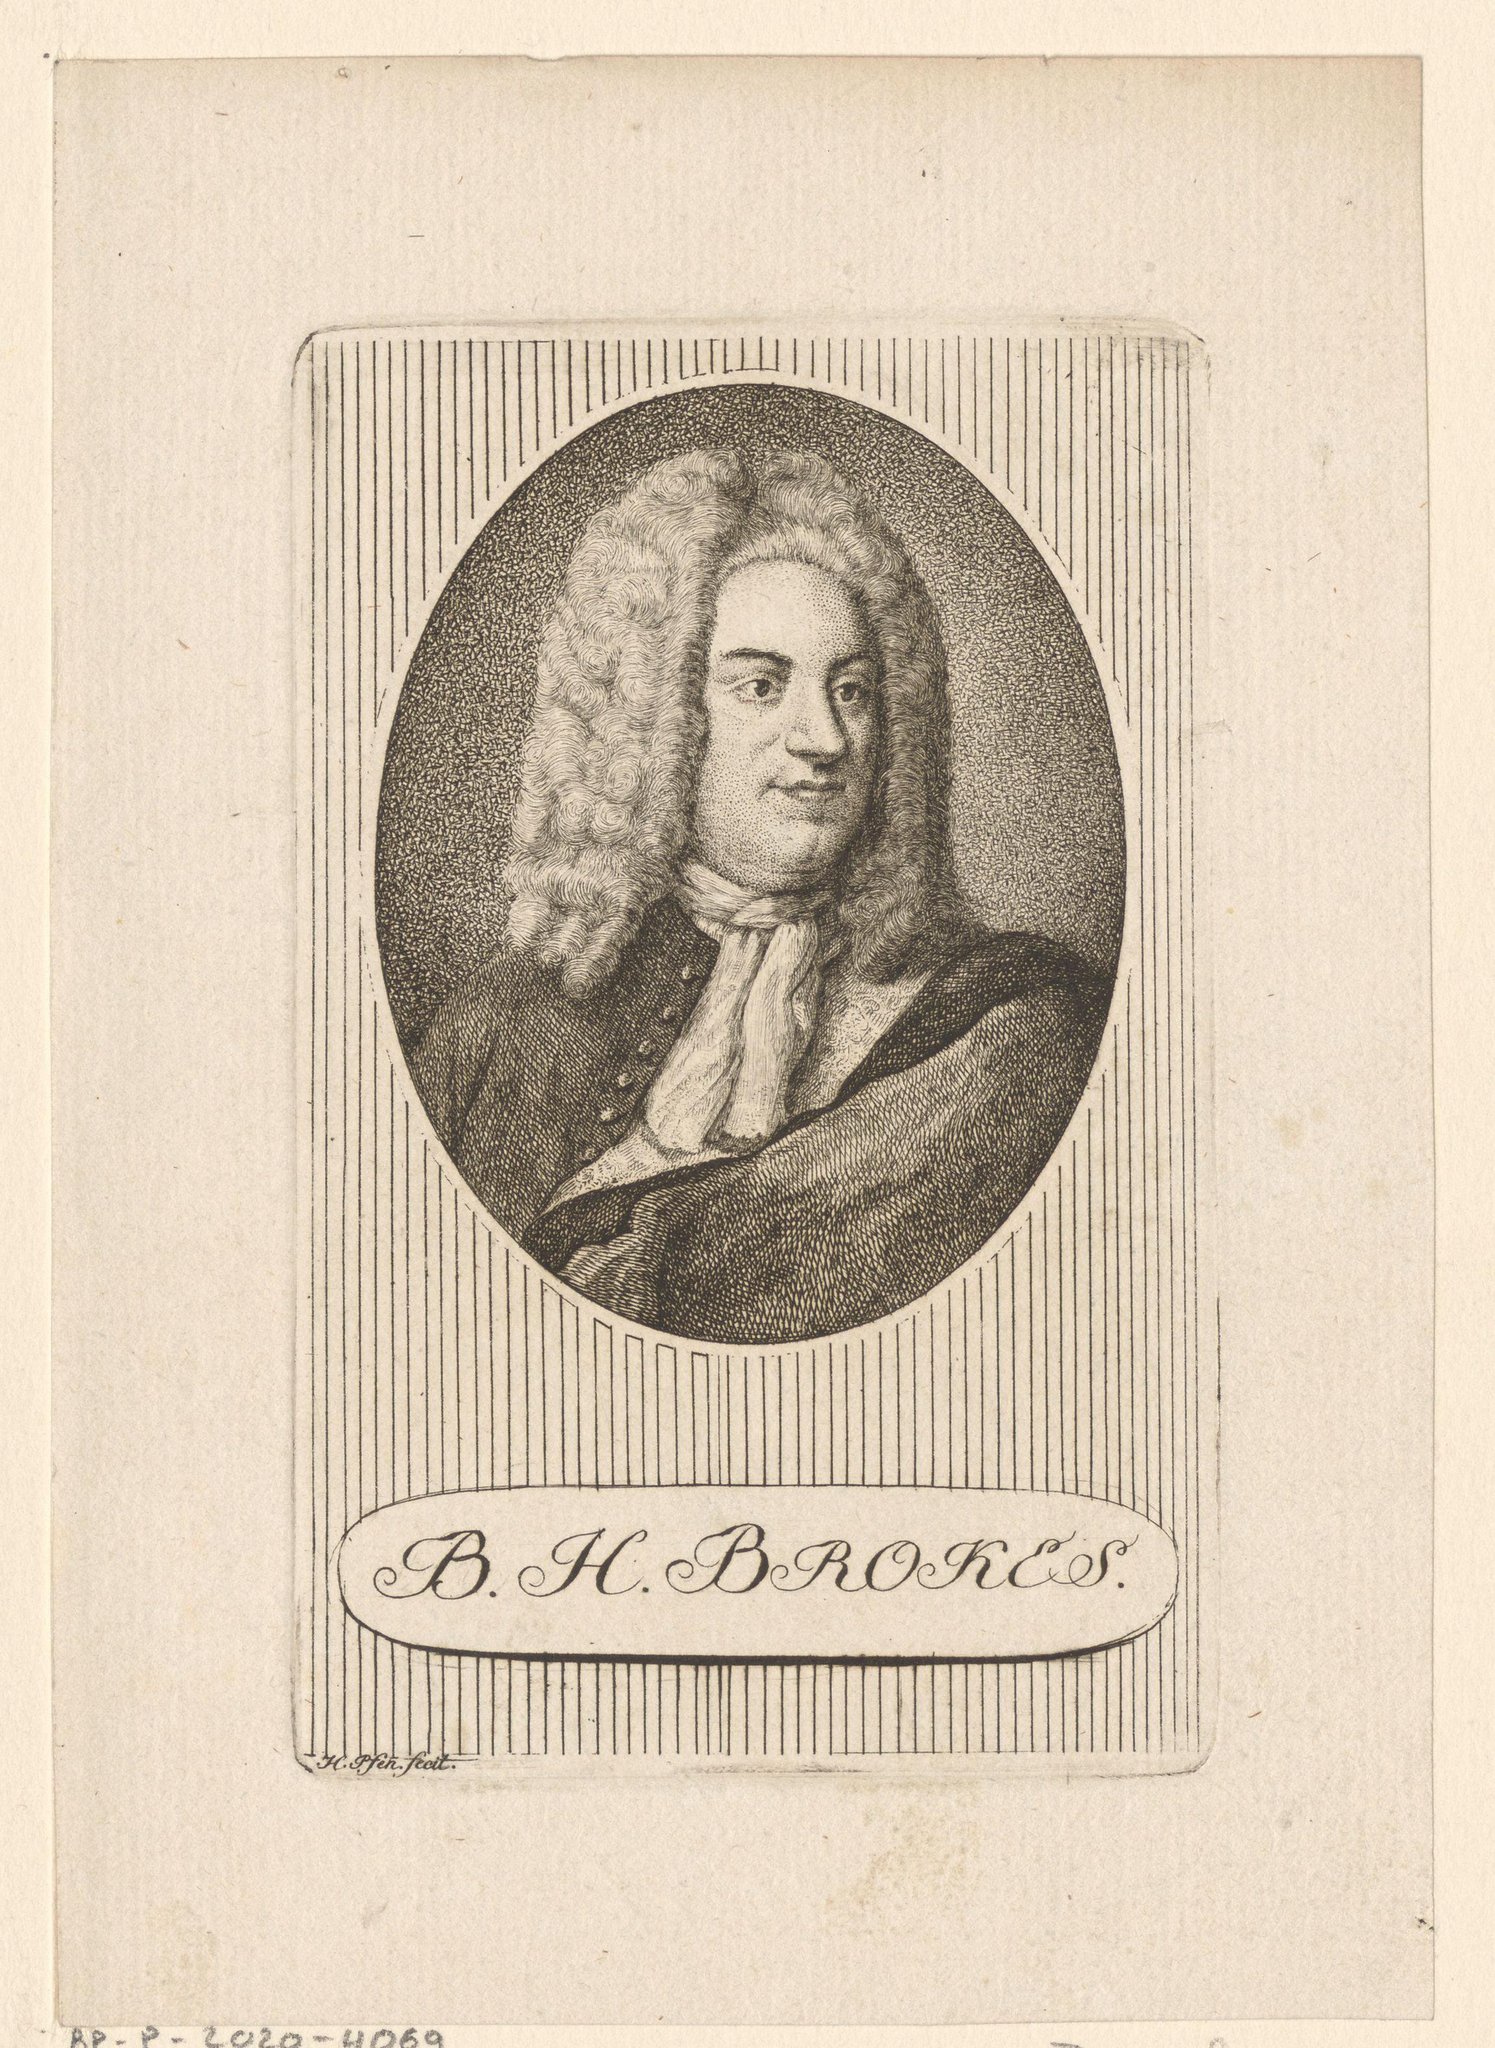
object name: print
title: Portret van Barthold Hinrich Brockes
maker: heinrich pfenninger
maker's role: print maker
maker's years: 1749-1815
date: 1759-1815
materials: paper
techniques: engraving, etching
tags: barthold hinrich brockes, historical persons, writer, poet, author